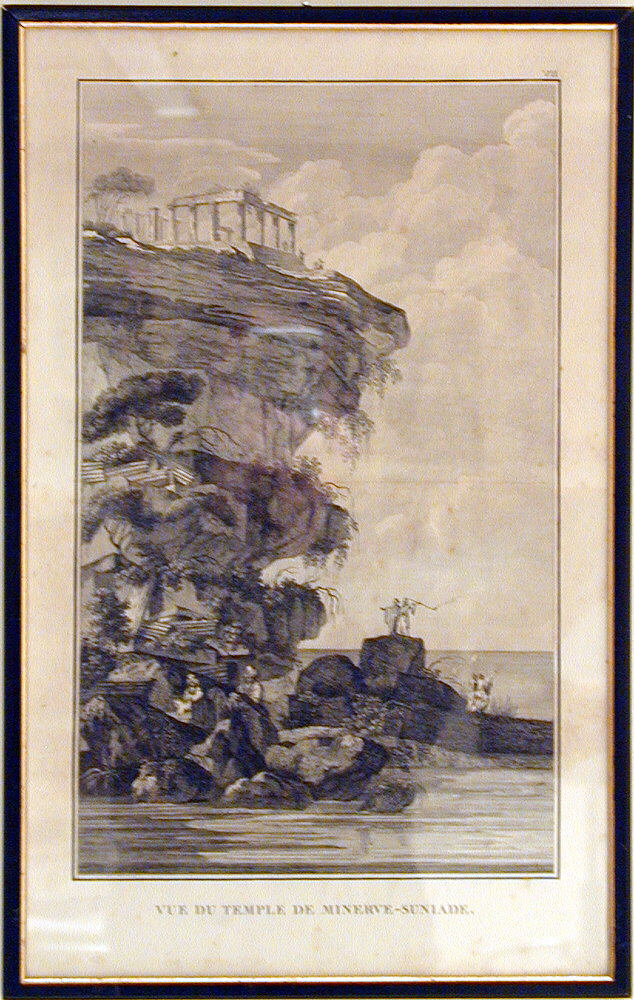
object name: engraving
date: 1701-1800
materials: ink, paper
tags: ruins,maps